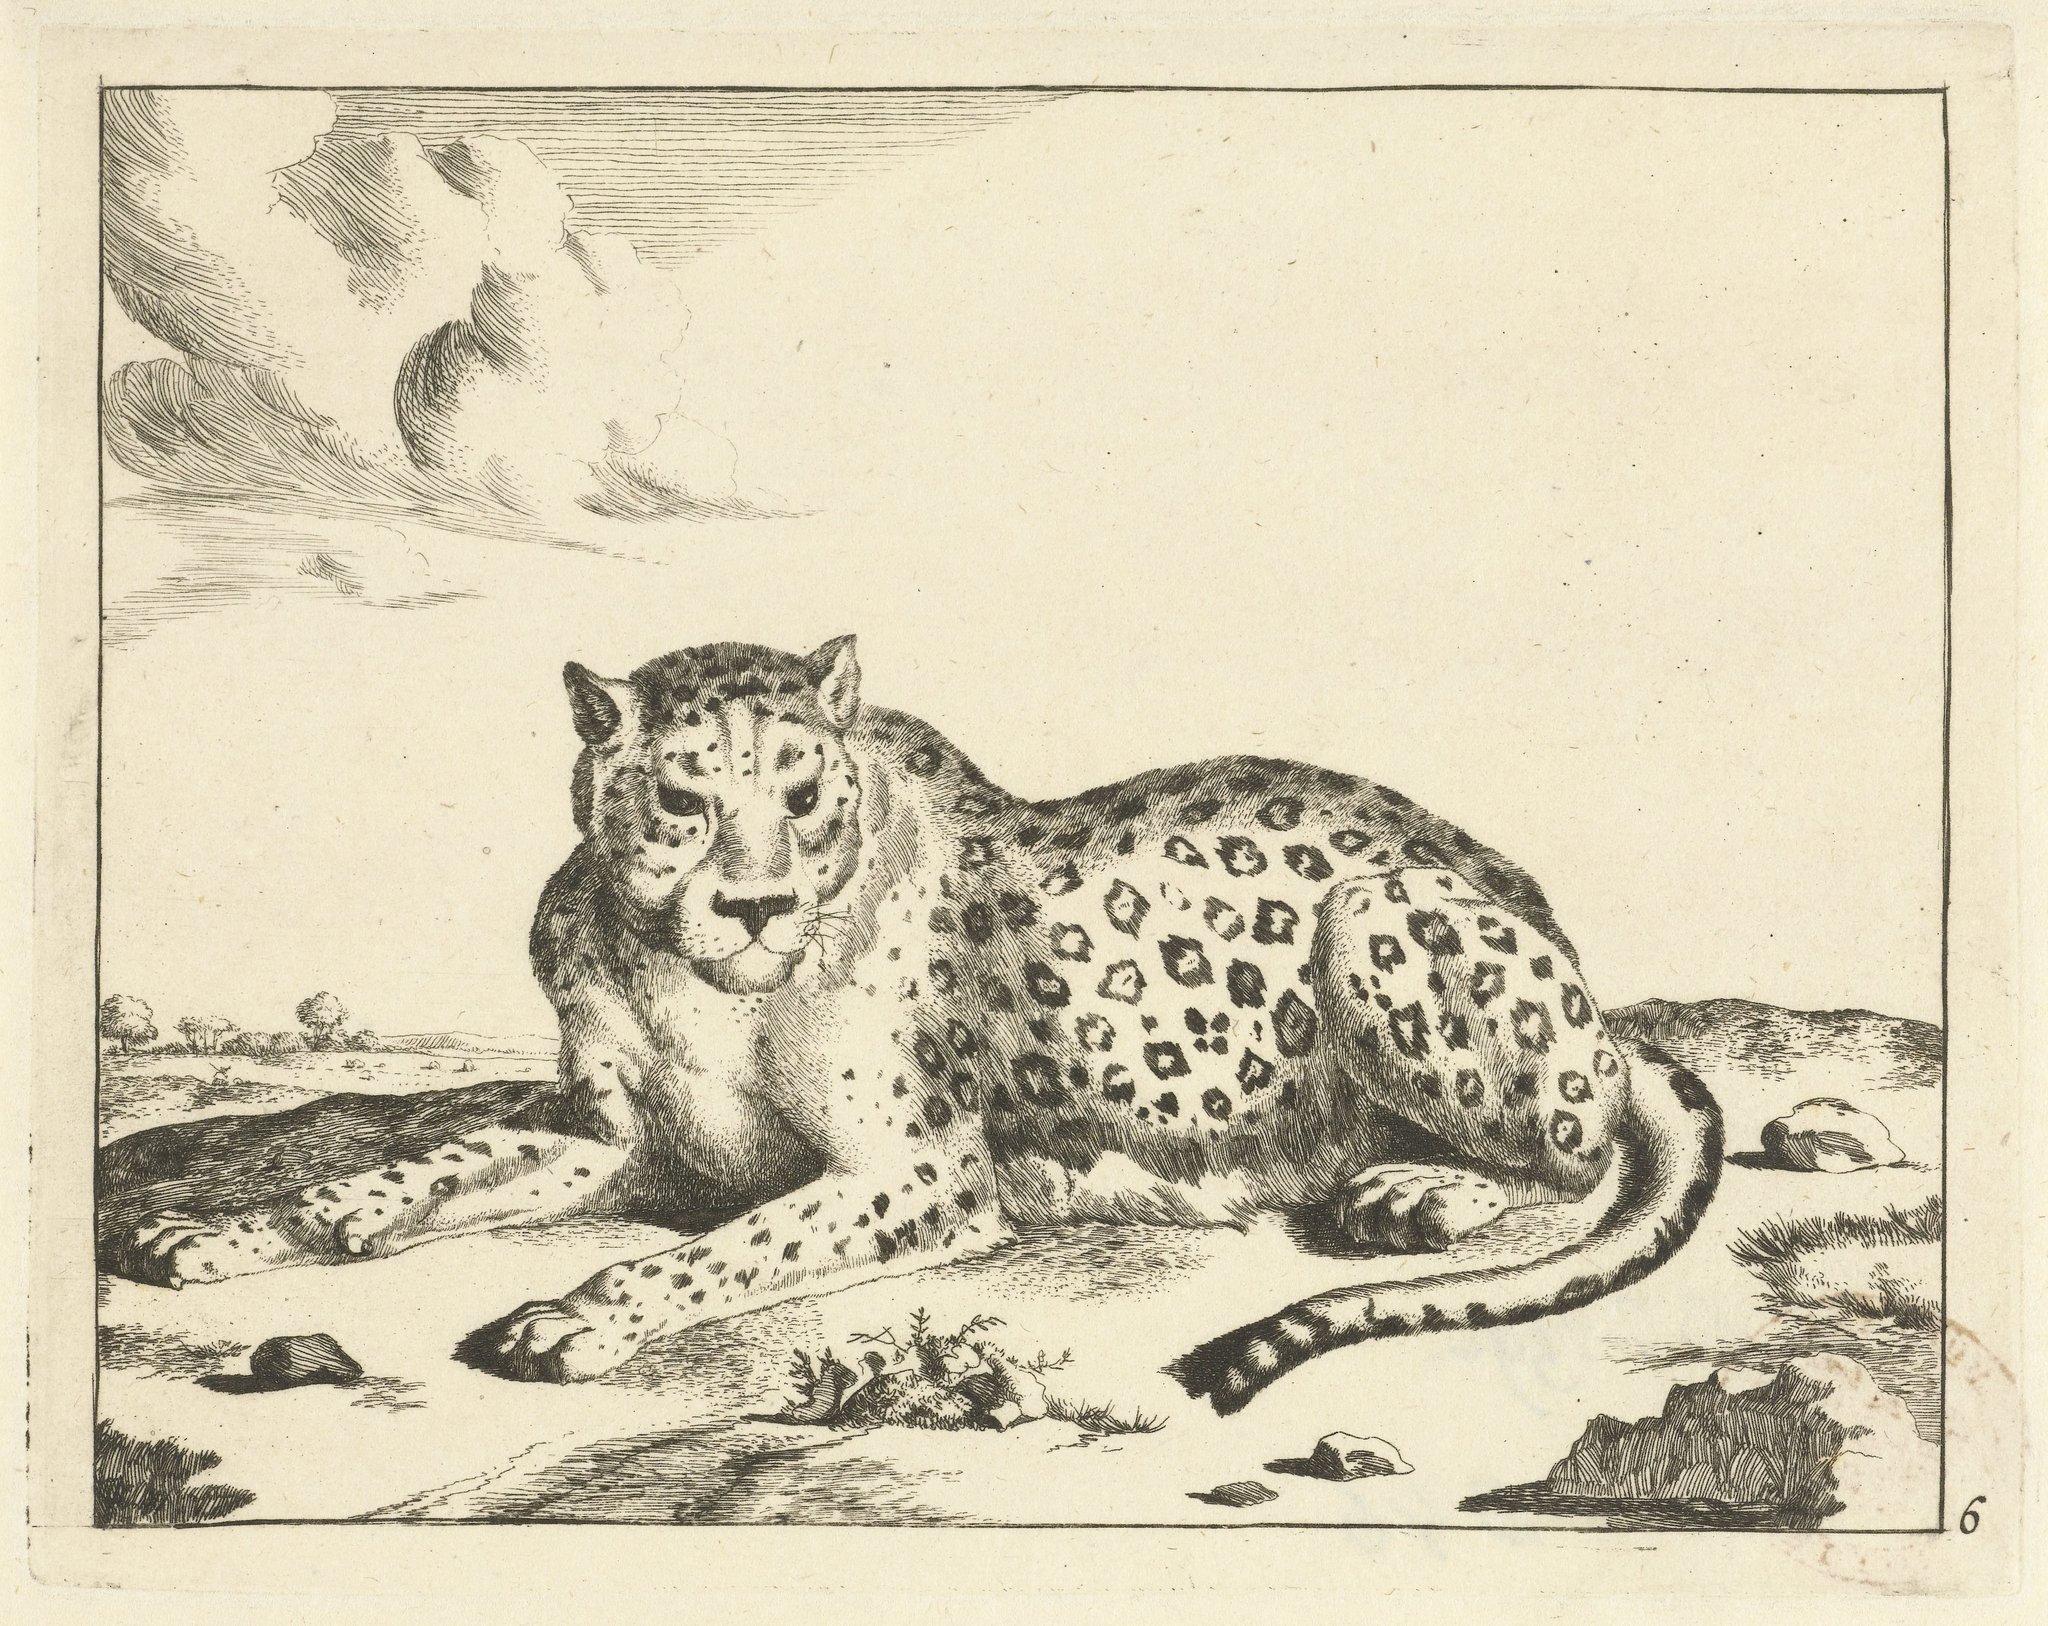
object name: print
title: Luipaarden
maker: marcus de bye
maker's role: print maker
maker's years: 1639-1688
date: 1657-1677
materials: paper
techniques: etching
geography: the hague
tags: beasts of prey, predatory animals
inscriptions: collector's mark: Lugt 240